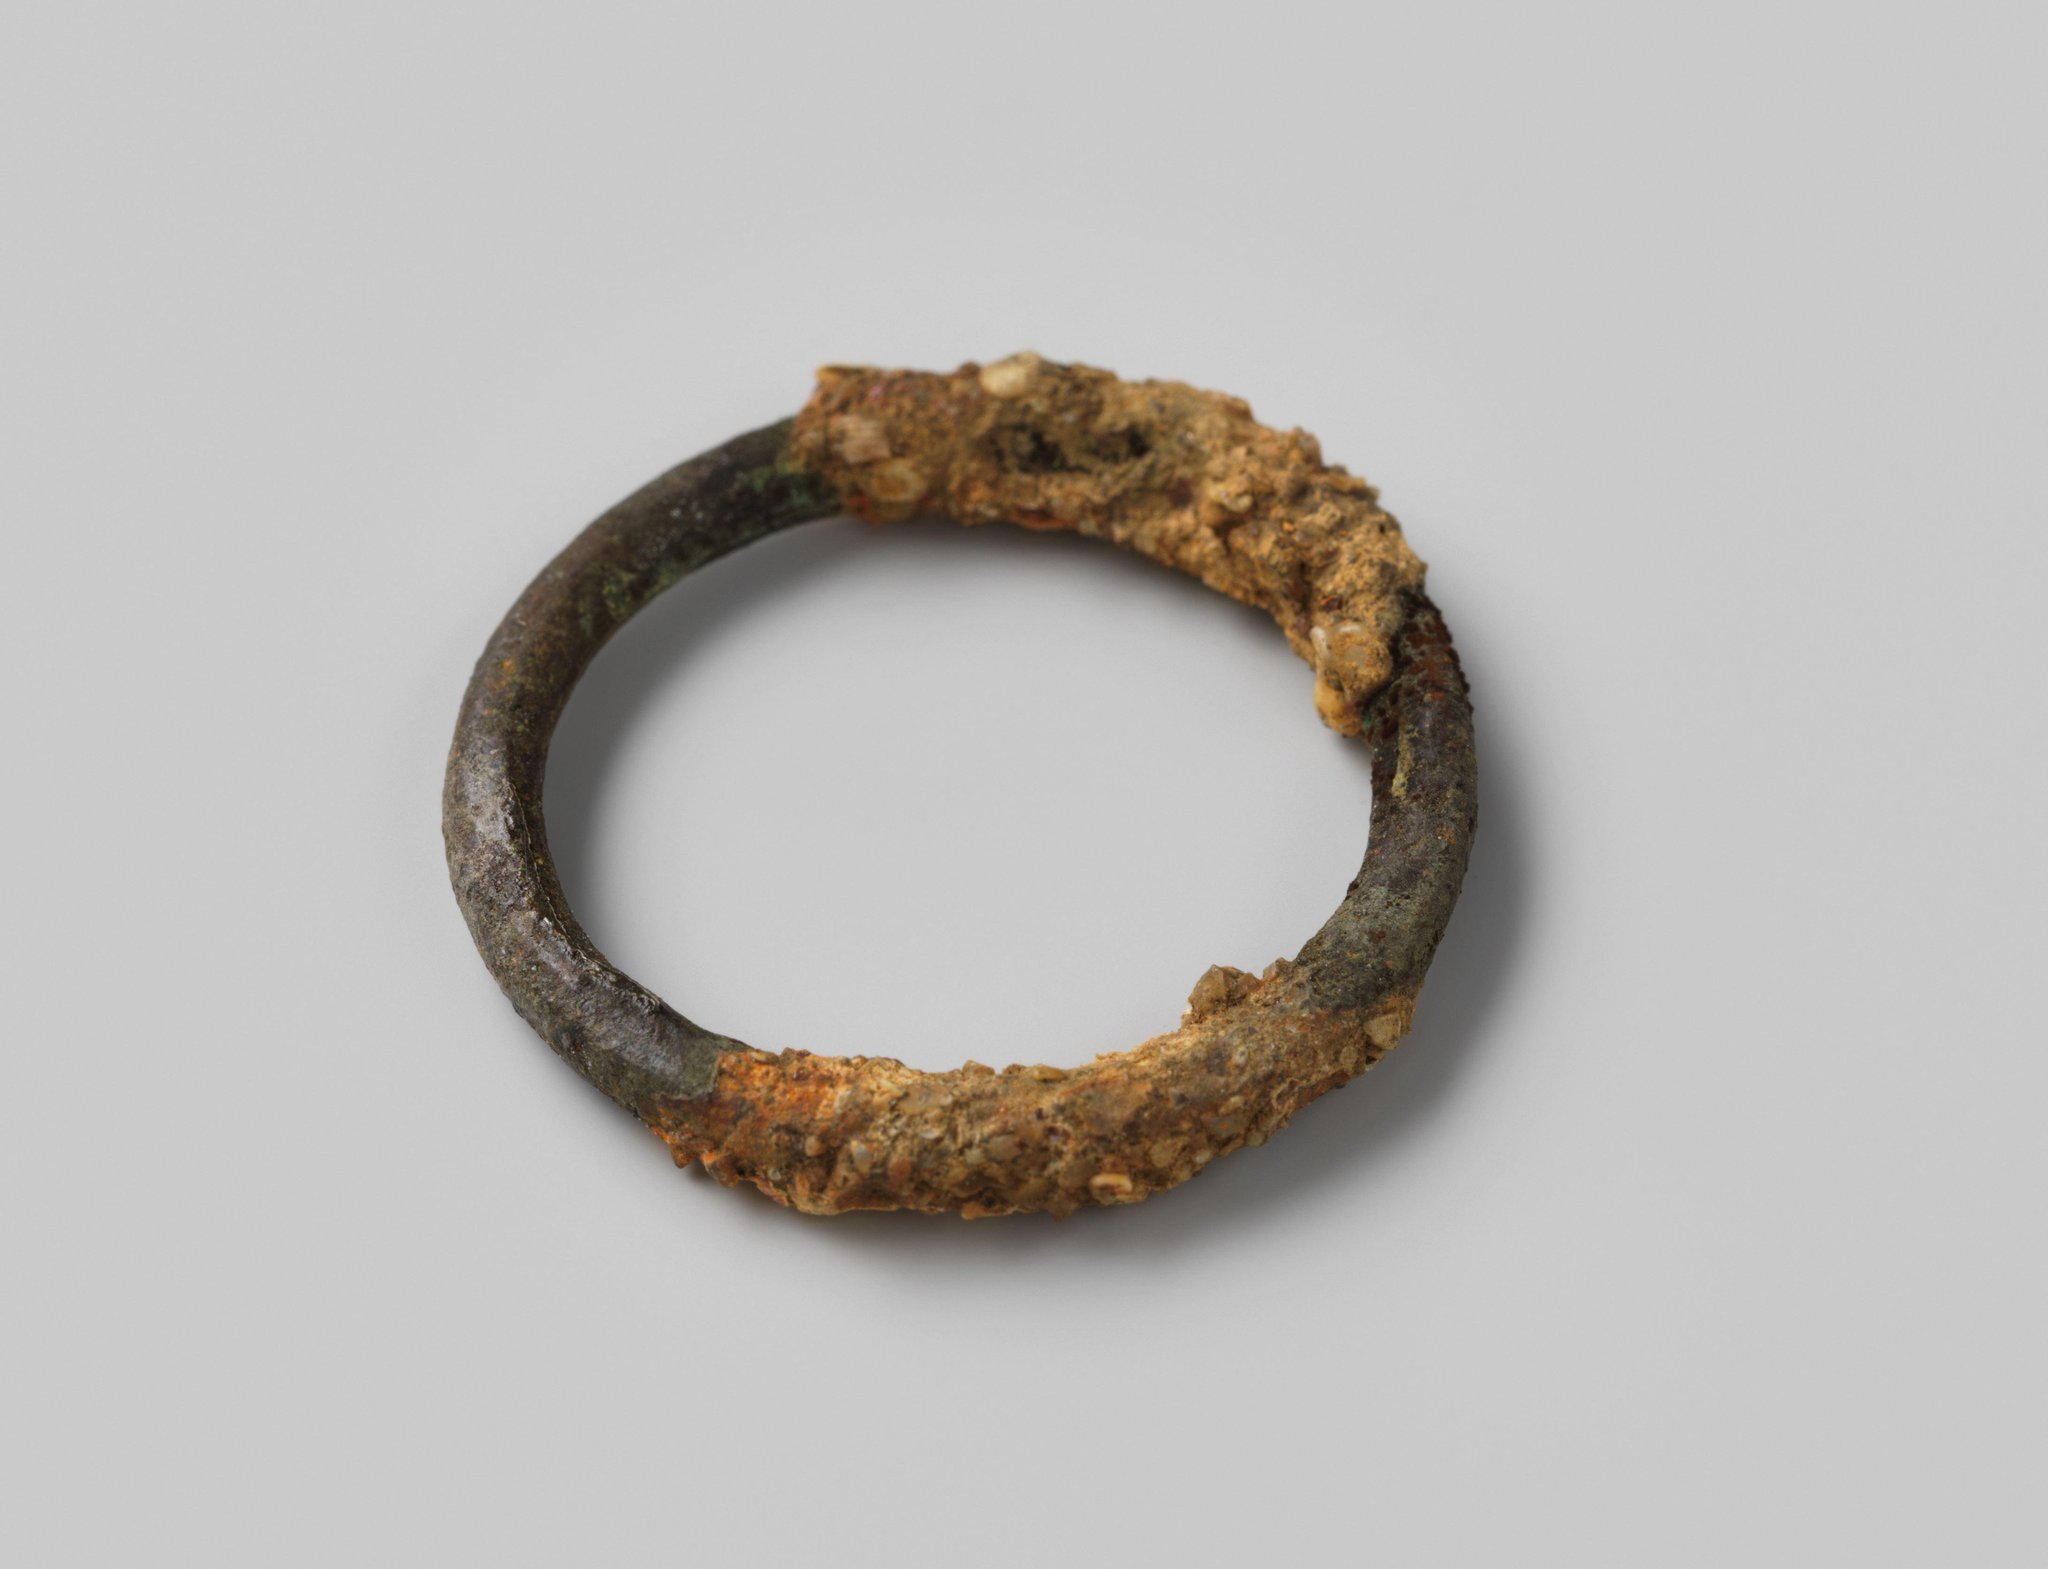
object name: ring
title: Ringvormig fragment uit het wrak van de Oost-Indiëvaarder Hollandia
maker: Anonymous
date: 1700-1743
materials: copper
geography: netherlands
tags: verenigde oostindische compagnie, hollandia (schip), annet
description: Varied parts or fragments, rings or ring-shaped fragments; sim. 80H704.